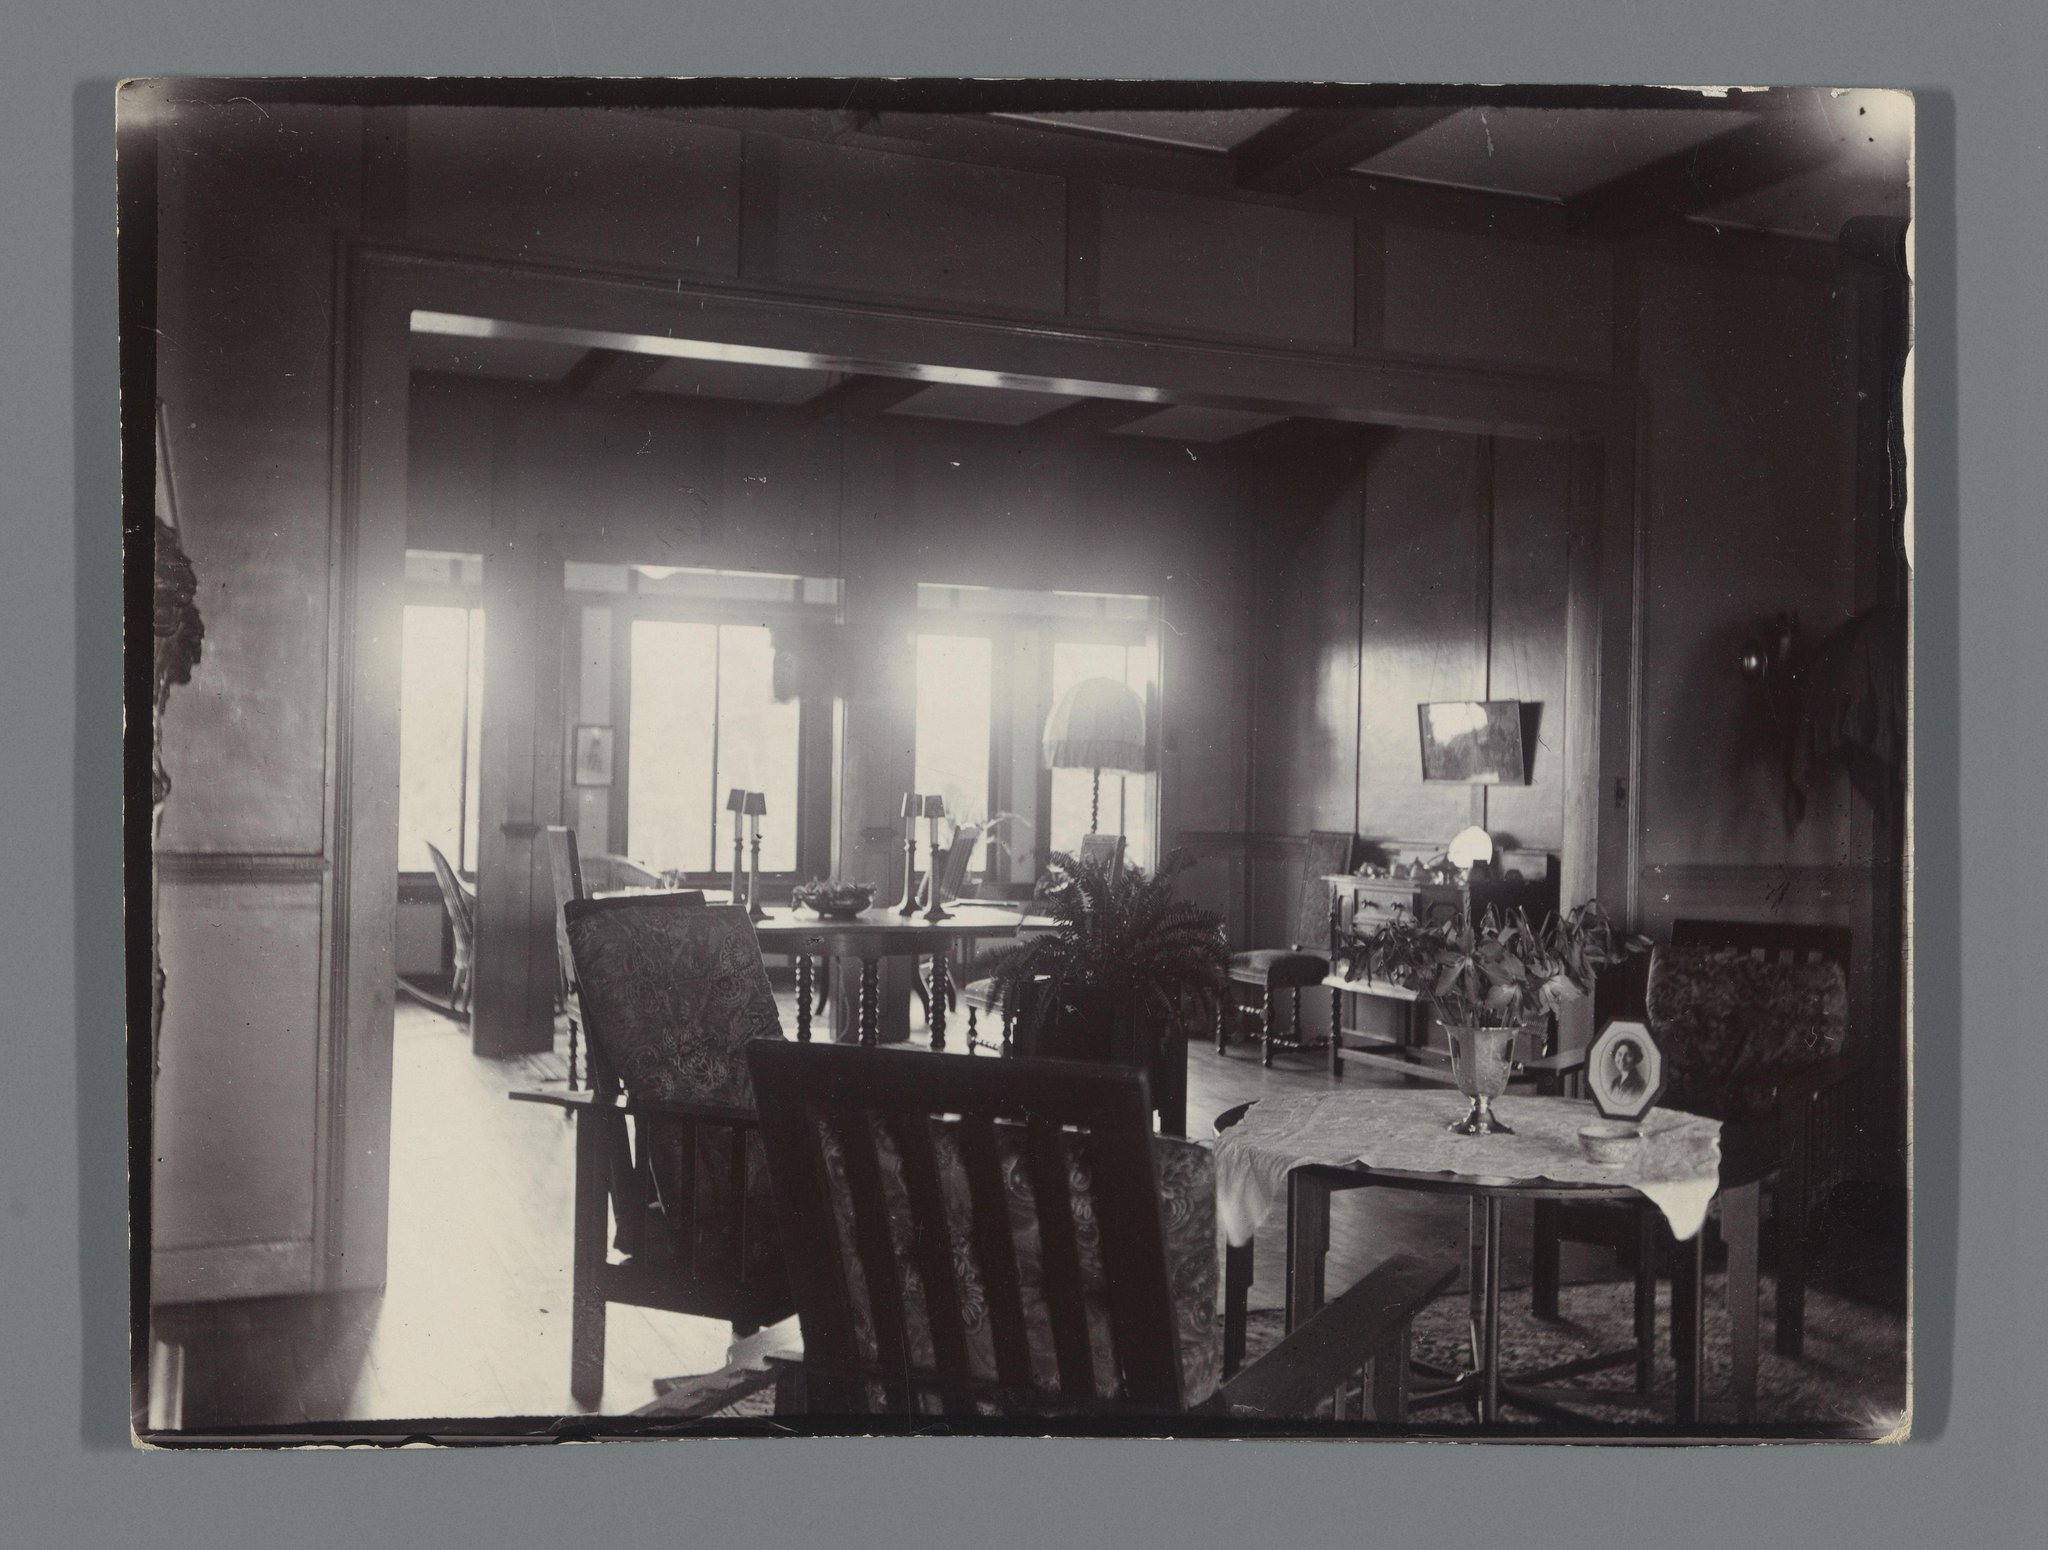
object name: photograph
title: Interieur van het huis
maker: Anonymous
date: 1925-1927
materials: photographic support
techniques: photography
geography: suriname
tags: jetten, familie, moengo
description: Interieur van een huis, waarschijnlijk het huis van de familie Jetten. Onderdeel van het ensemble met foto's van de familie van ingenieur Jetten in de mijnbouwstad Moengo in Suriname.